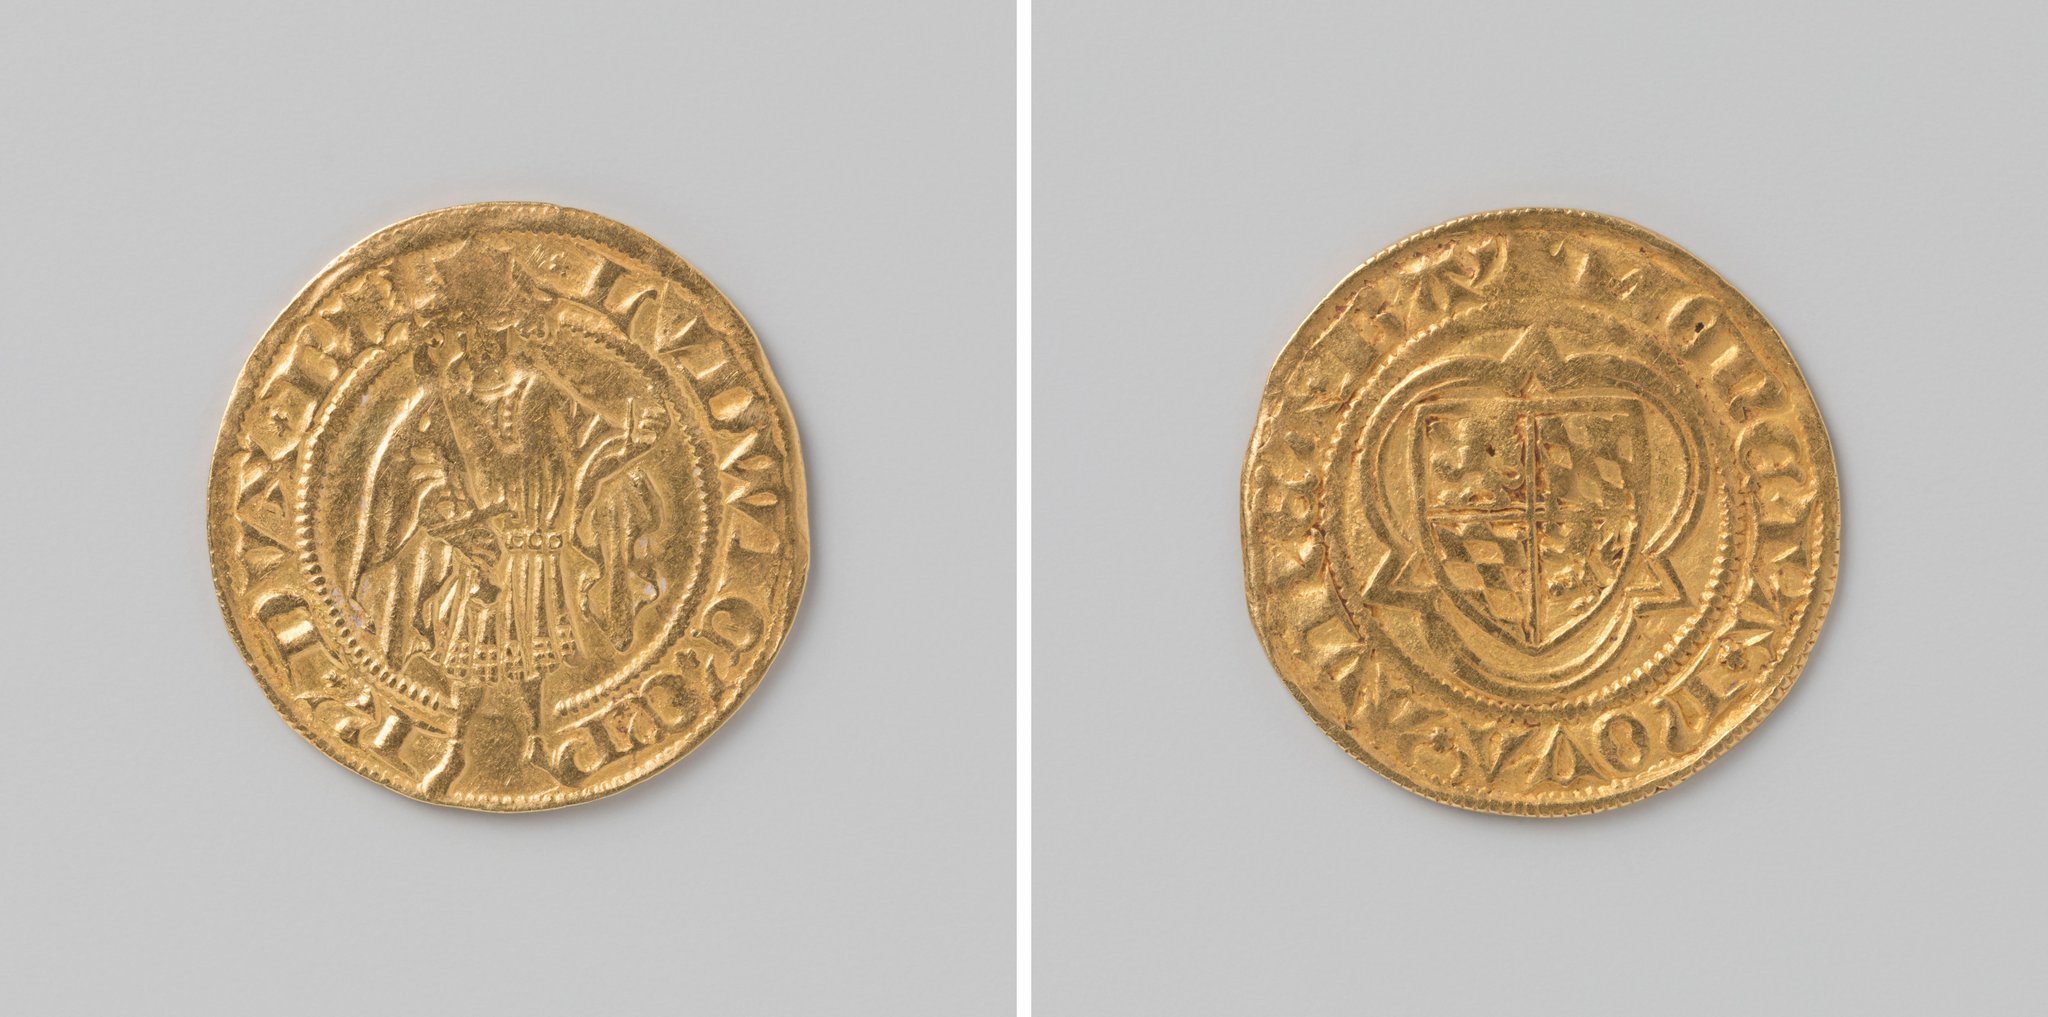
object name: rijnsgulden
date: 1430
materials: gold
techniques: striking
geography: bacharach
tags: germany, brielle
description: Opgegraven in de tuin van het in 1557 gestichte Merula-weeshuis te Brielle.